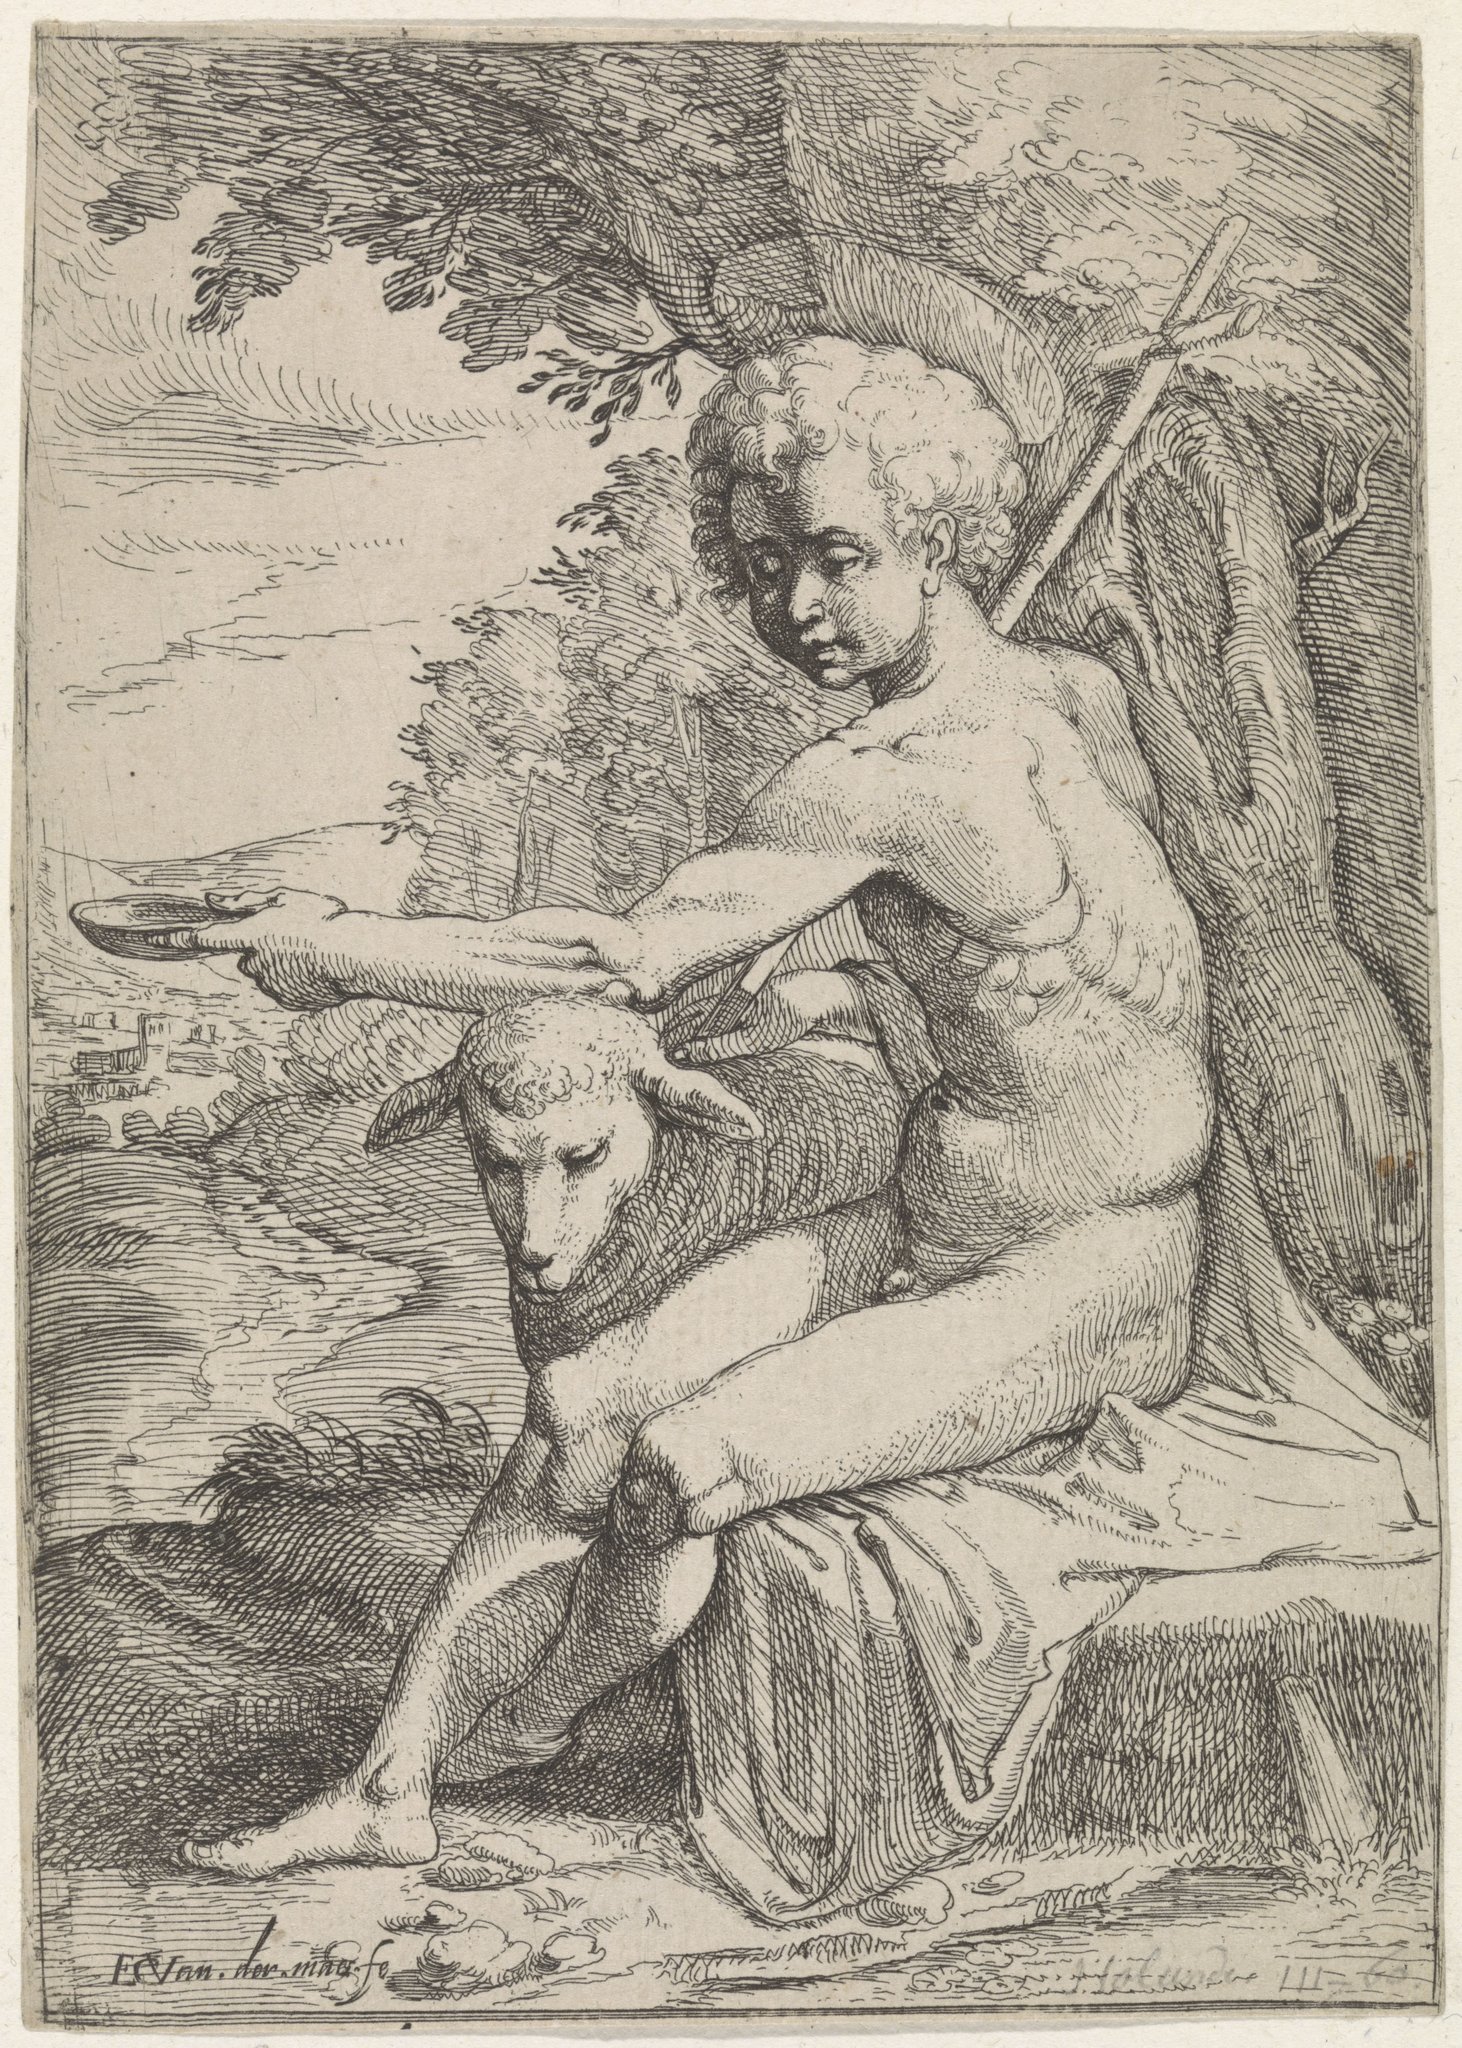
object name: print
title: Johannes de Doper in de woestijn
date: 1587-1647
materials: paper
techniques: etching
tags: john the baptist in the wilderness, usually accompanied by a lamb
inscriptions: collector's mark: Lugt 2228, collector's mark: Lugt 2760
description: Johannes de Doper bij een boom, met in zijn hand een nap die verwijst naar zijn schamele voedsel van honing en sprinkhanen. Naast hem een lam.